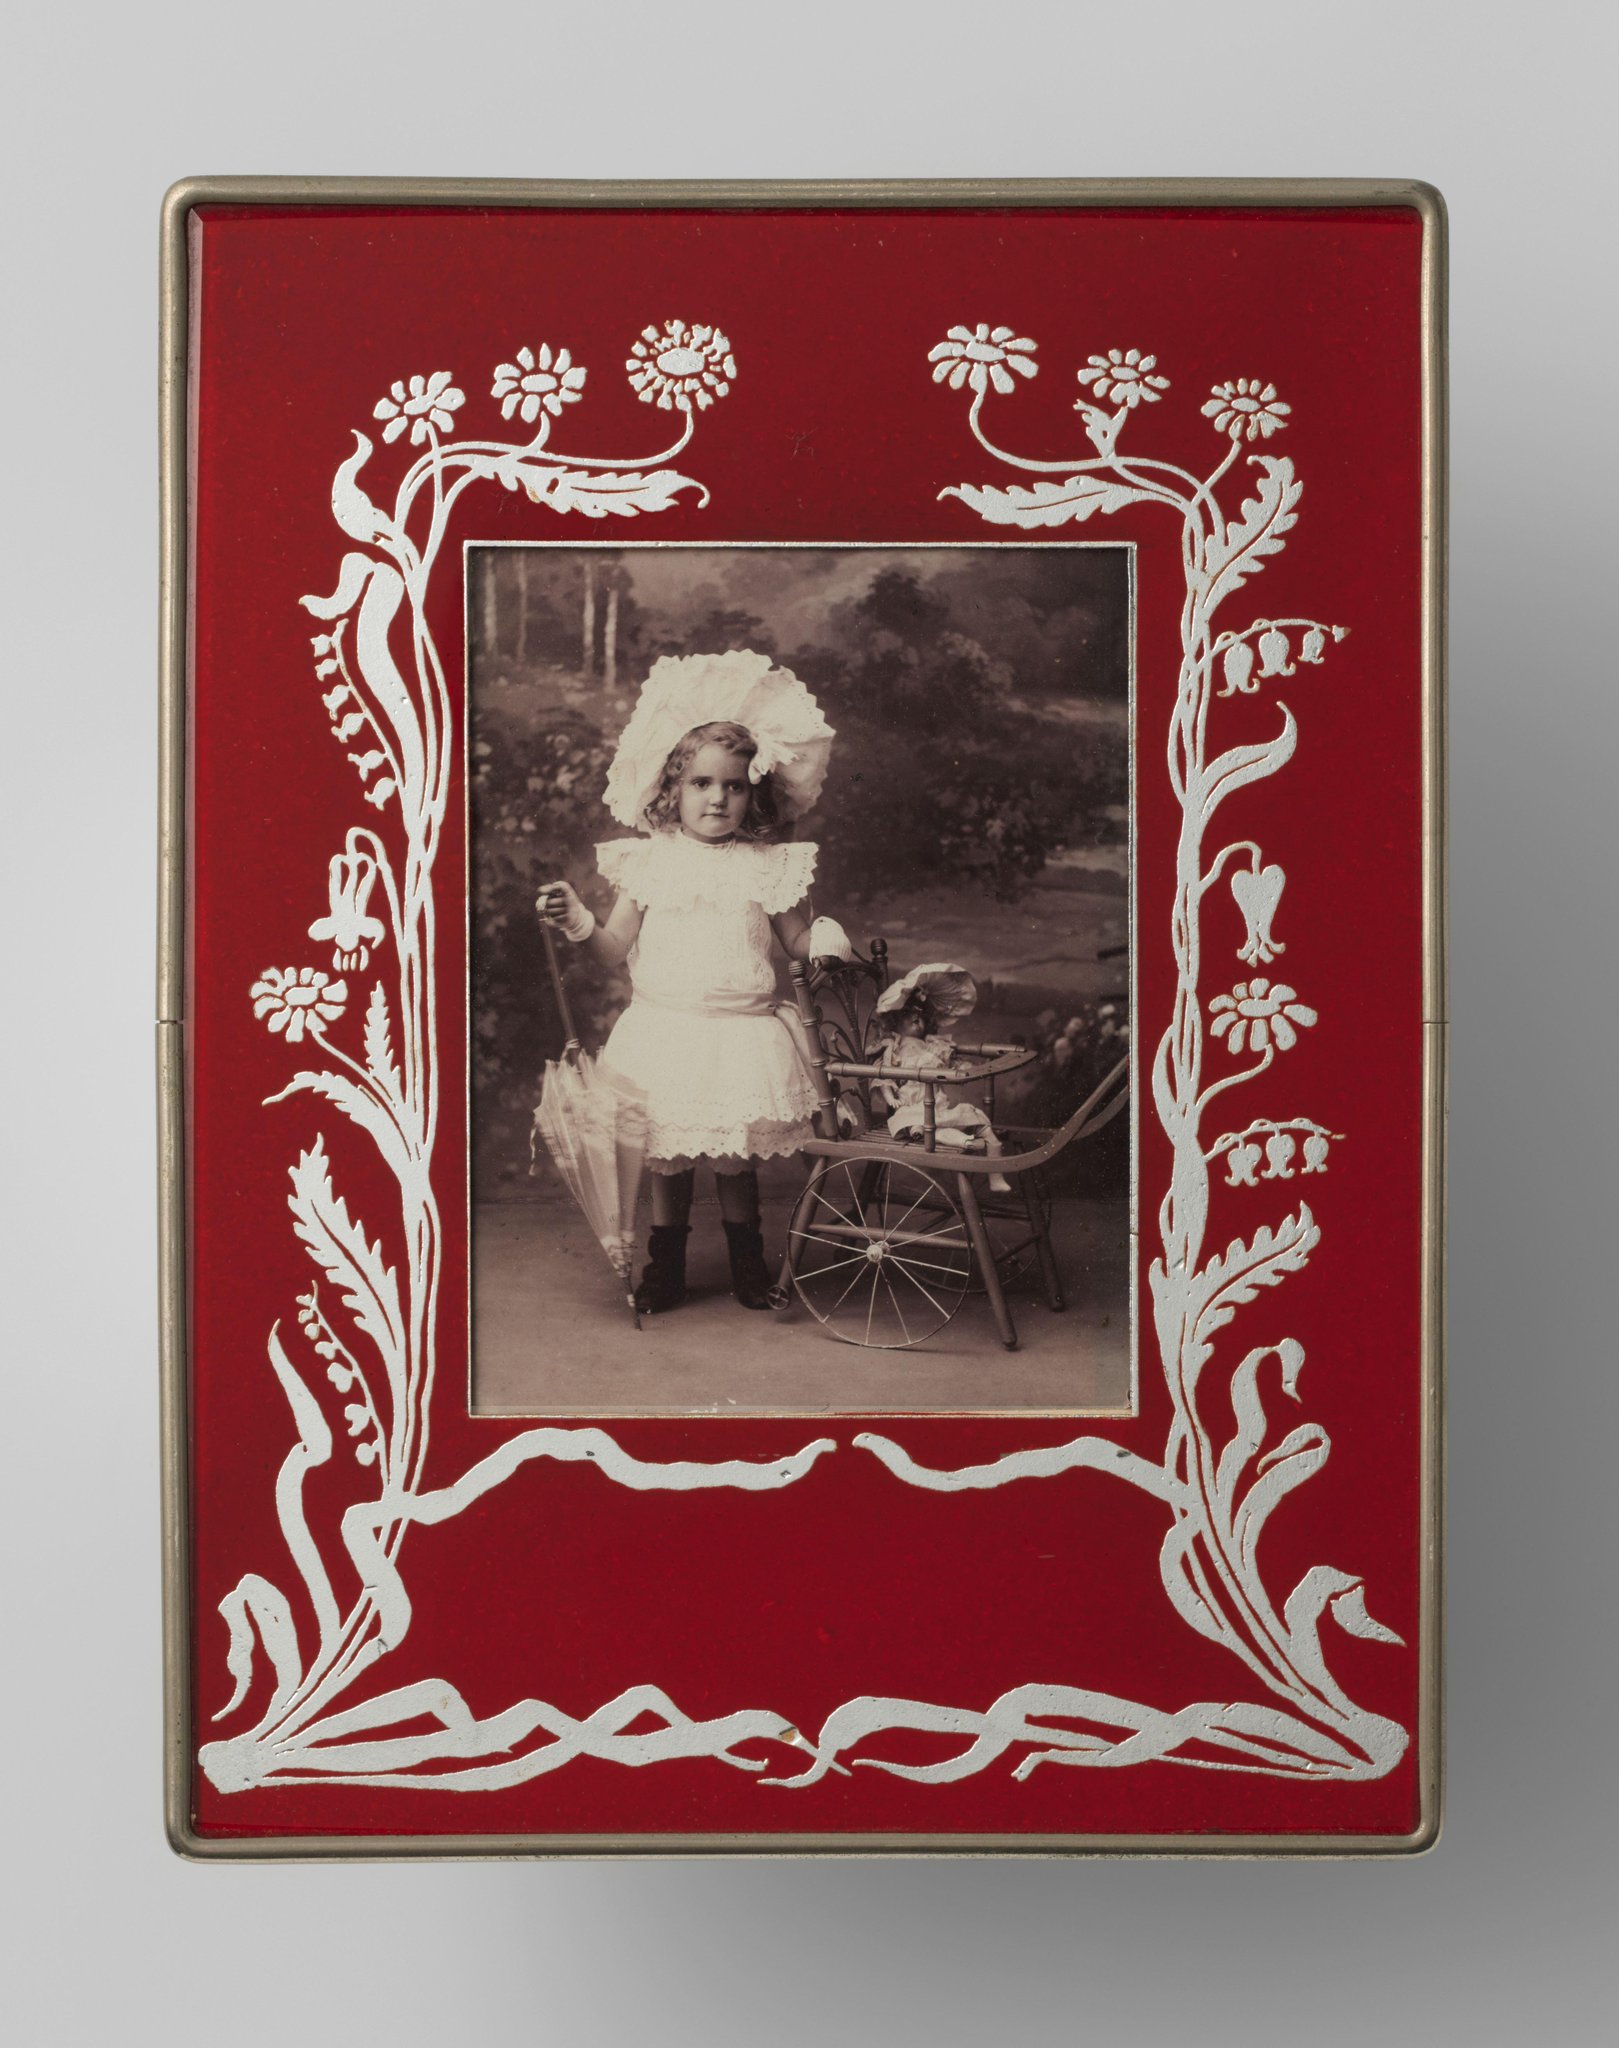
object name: frame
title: Portret van een onbekend meisje met een poppenwagen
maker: Anonymous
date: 1880-1900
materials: paper, cardboard, glass, metal, wood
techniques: gelatin silver print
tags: baby-carriage, pram, perambulator, girl (child between toddler and youth), anonymous historical person portrayed